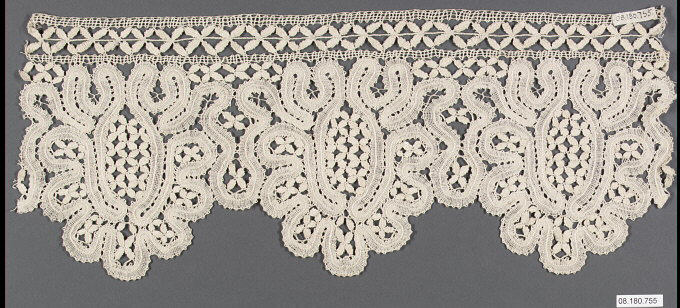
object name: piece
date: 1801-1900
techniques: lace